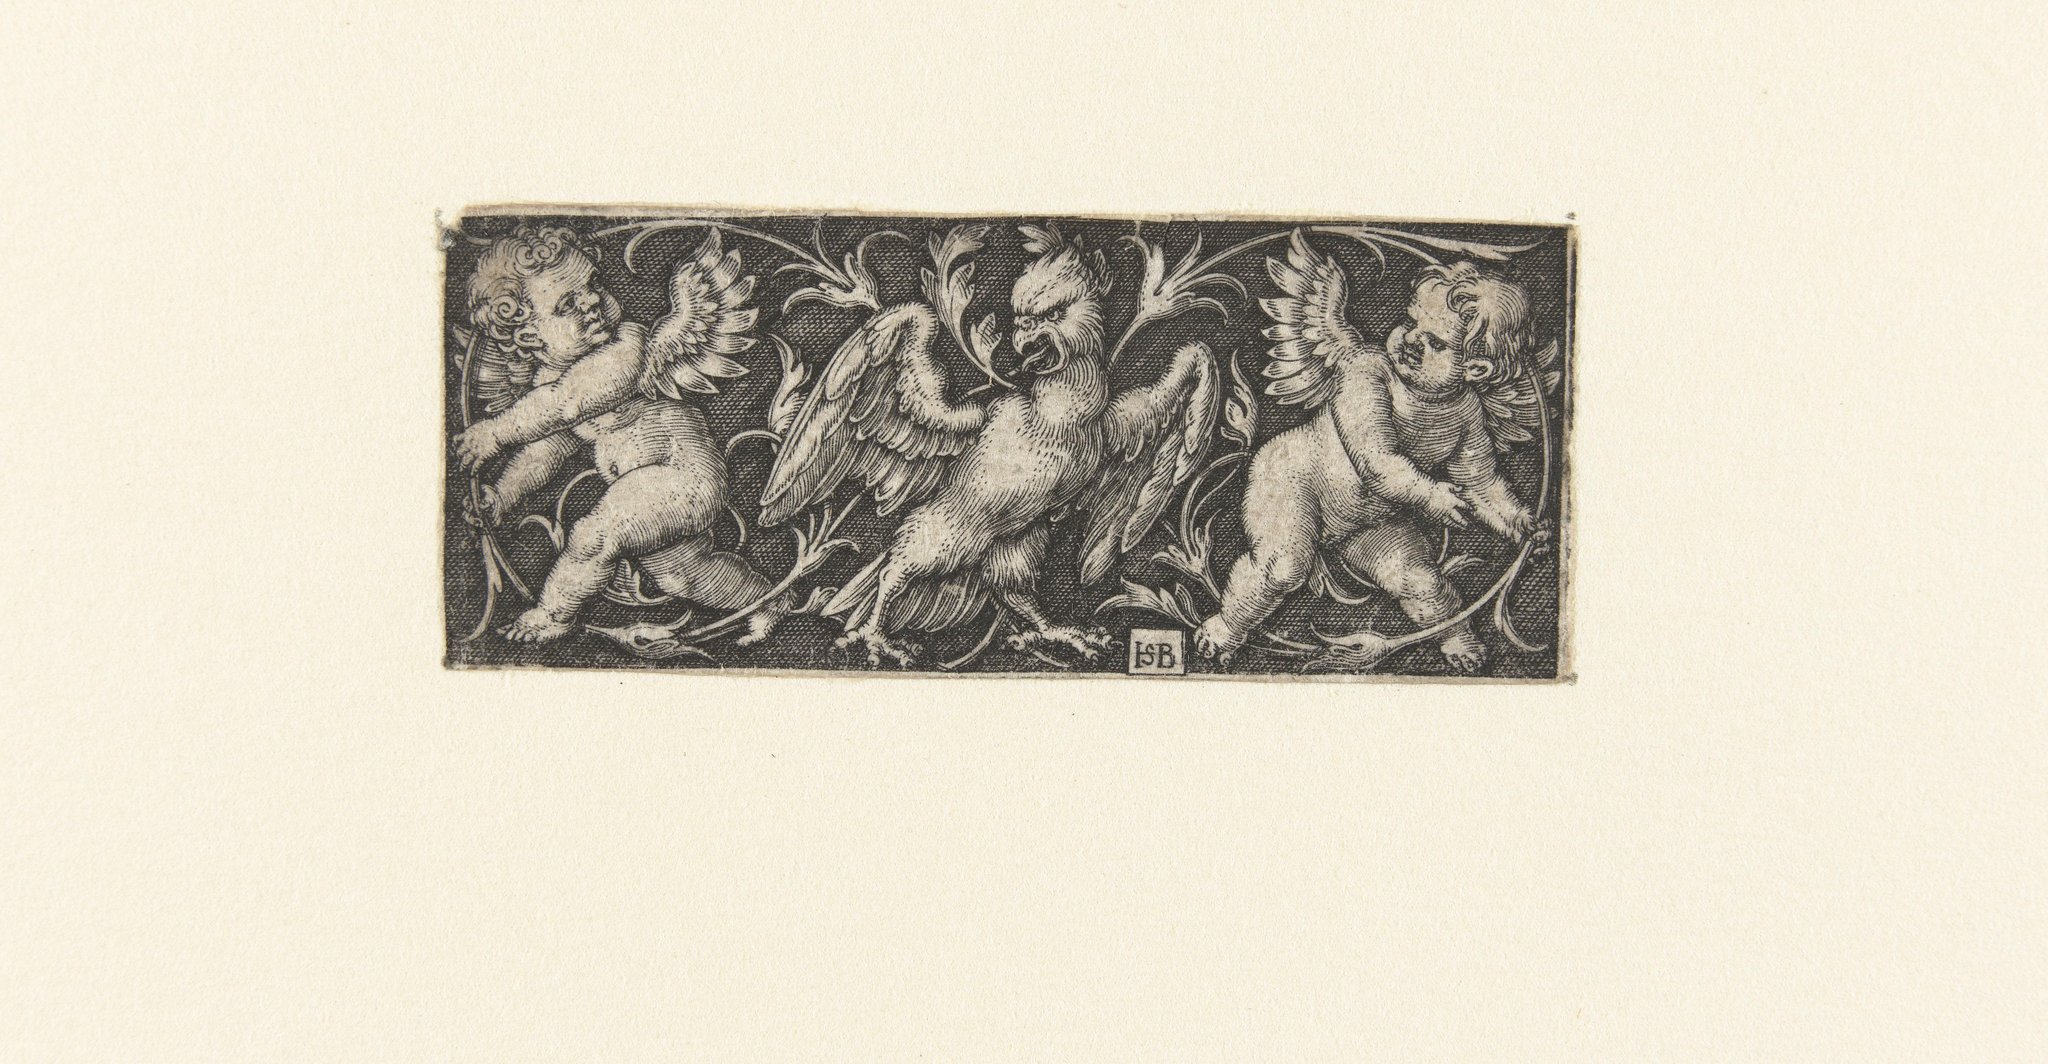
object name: ornament print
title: Friezen met grotesken, putti en bladranken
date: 1510-1544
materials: paper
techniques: engraving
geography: germany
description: Gearceerde achtergrond. 1 blad van 4 bladen.